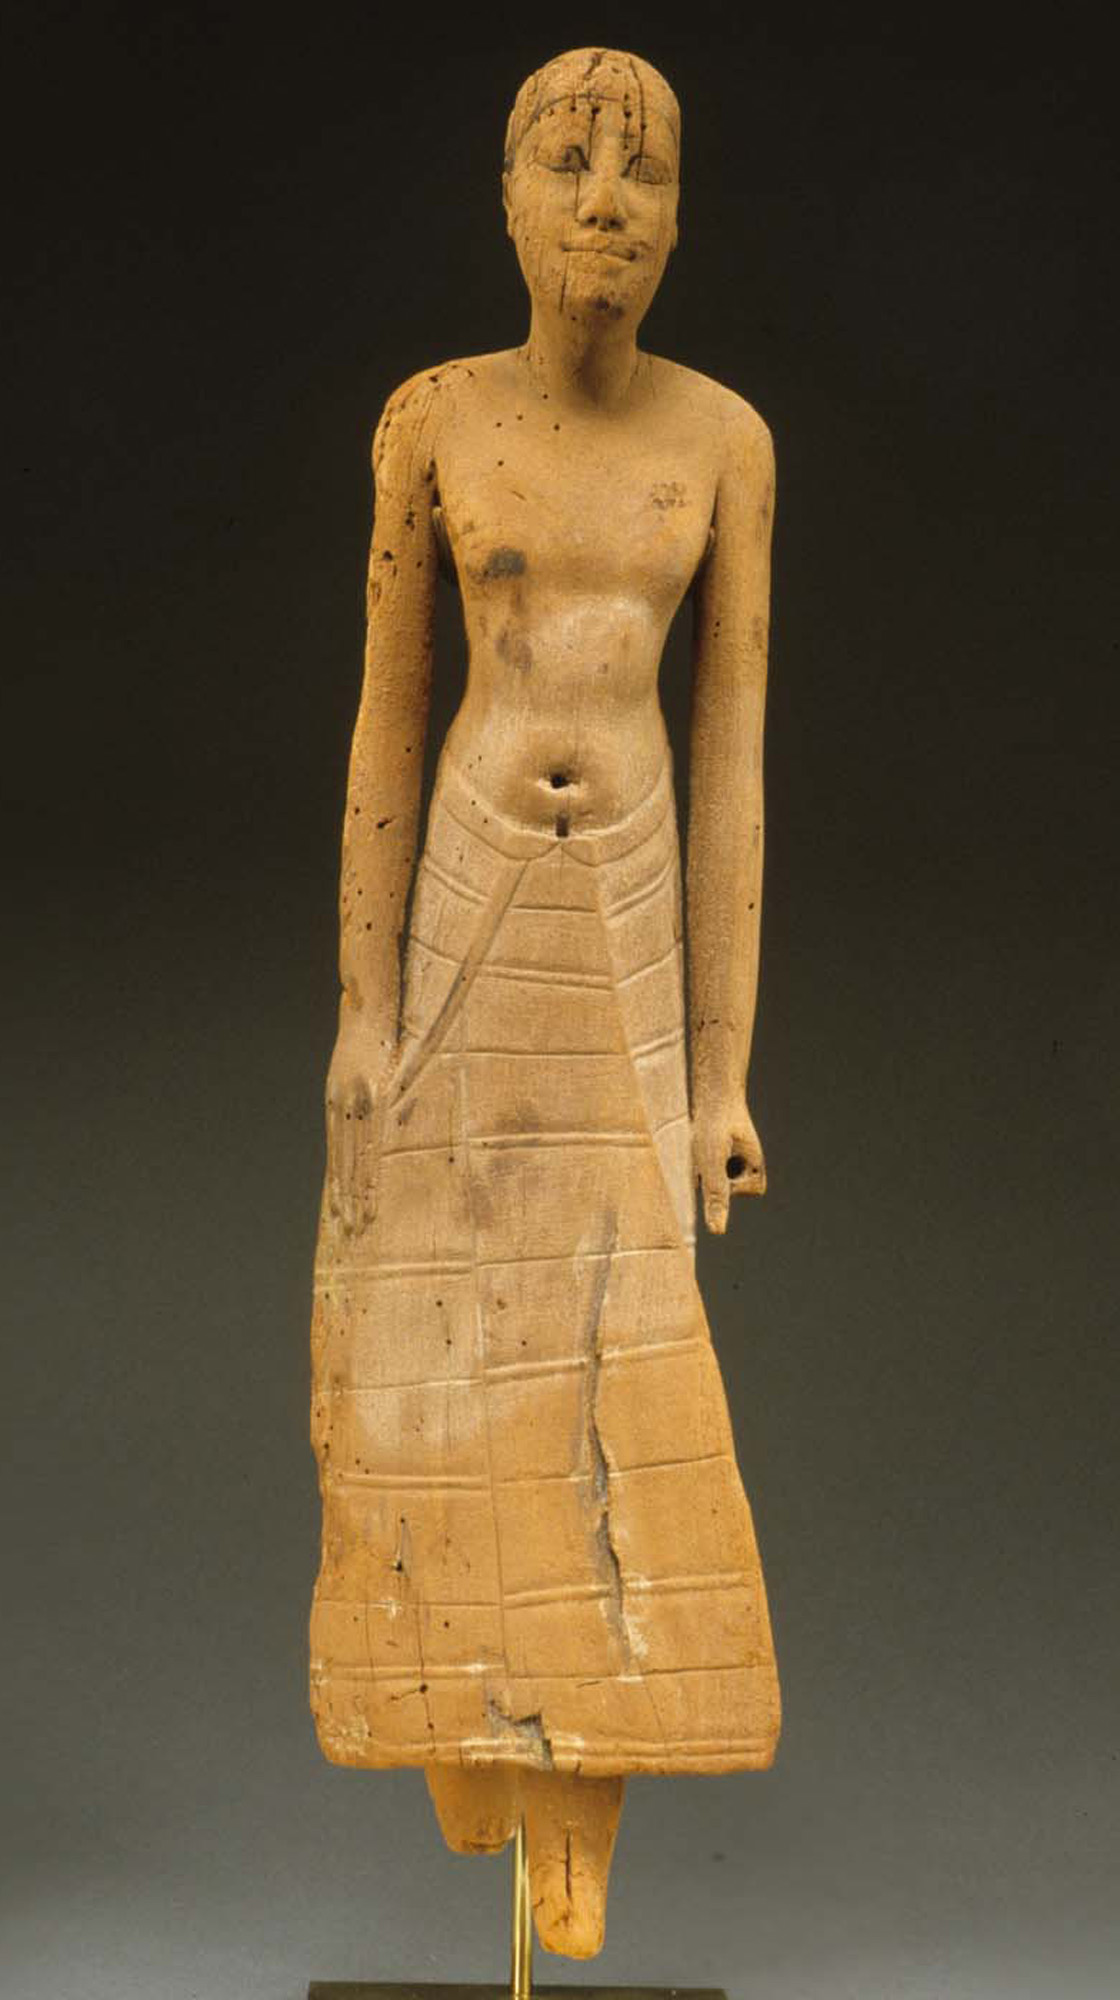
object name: statue, man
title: Standing Man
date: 2200-2100 BCE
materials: wood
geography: egypt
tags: men